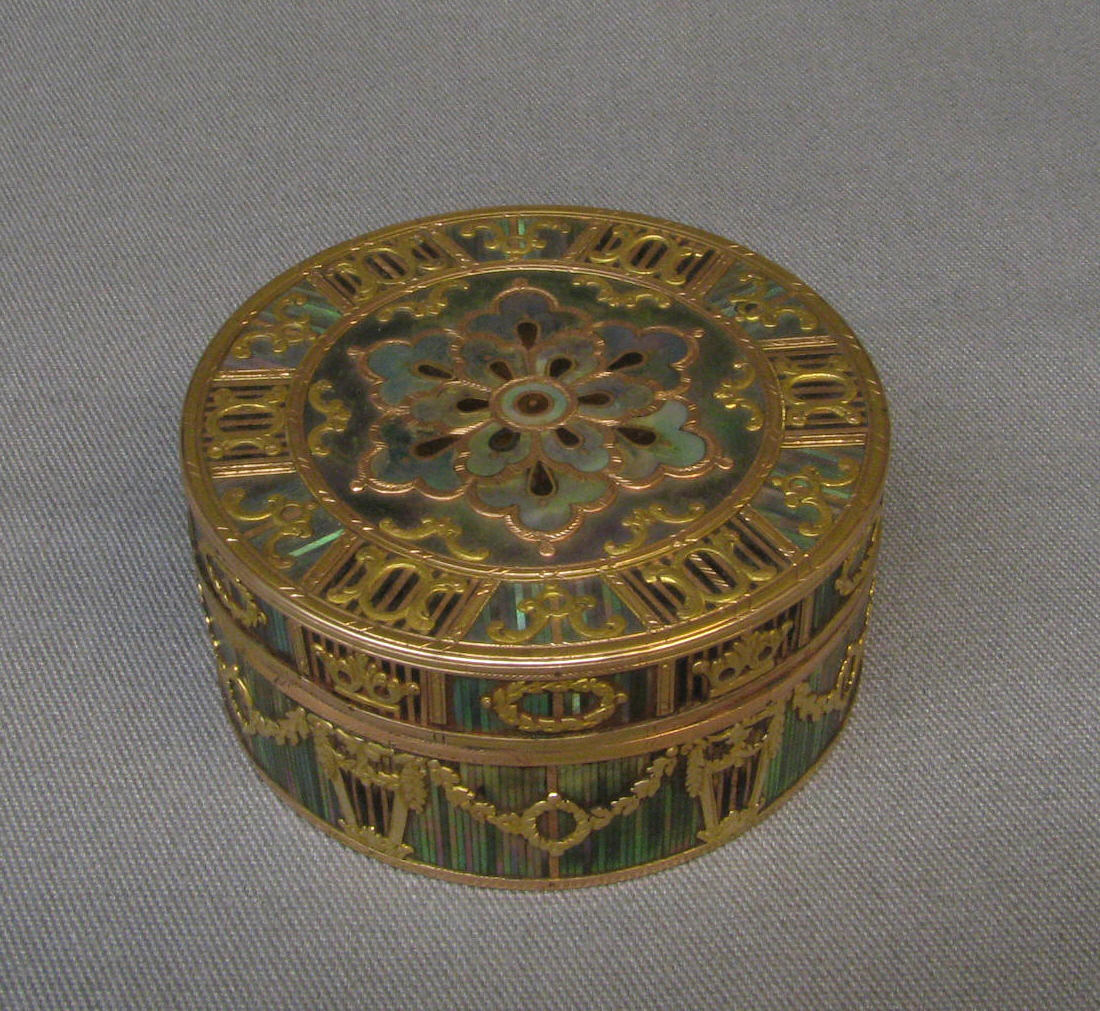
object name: box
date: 1806-1807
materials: gold, mother of pearl